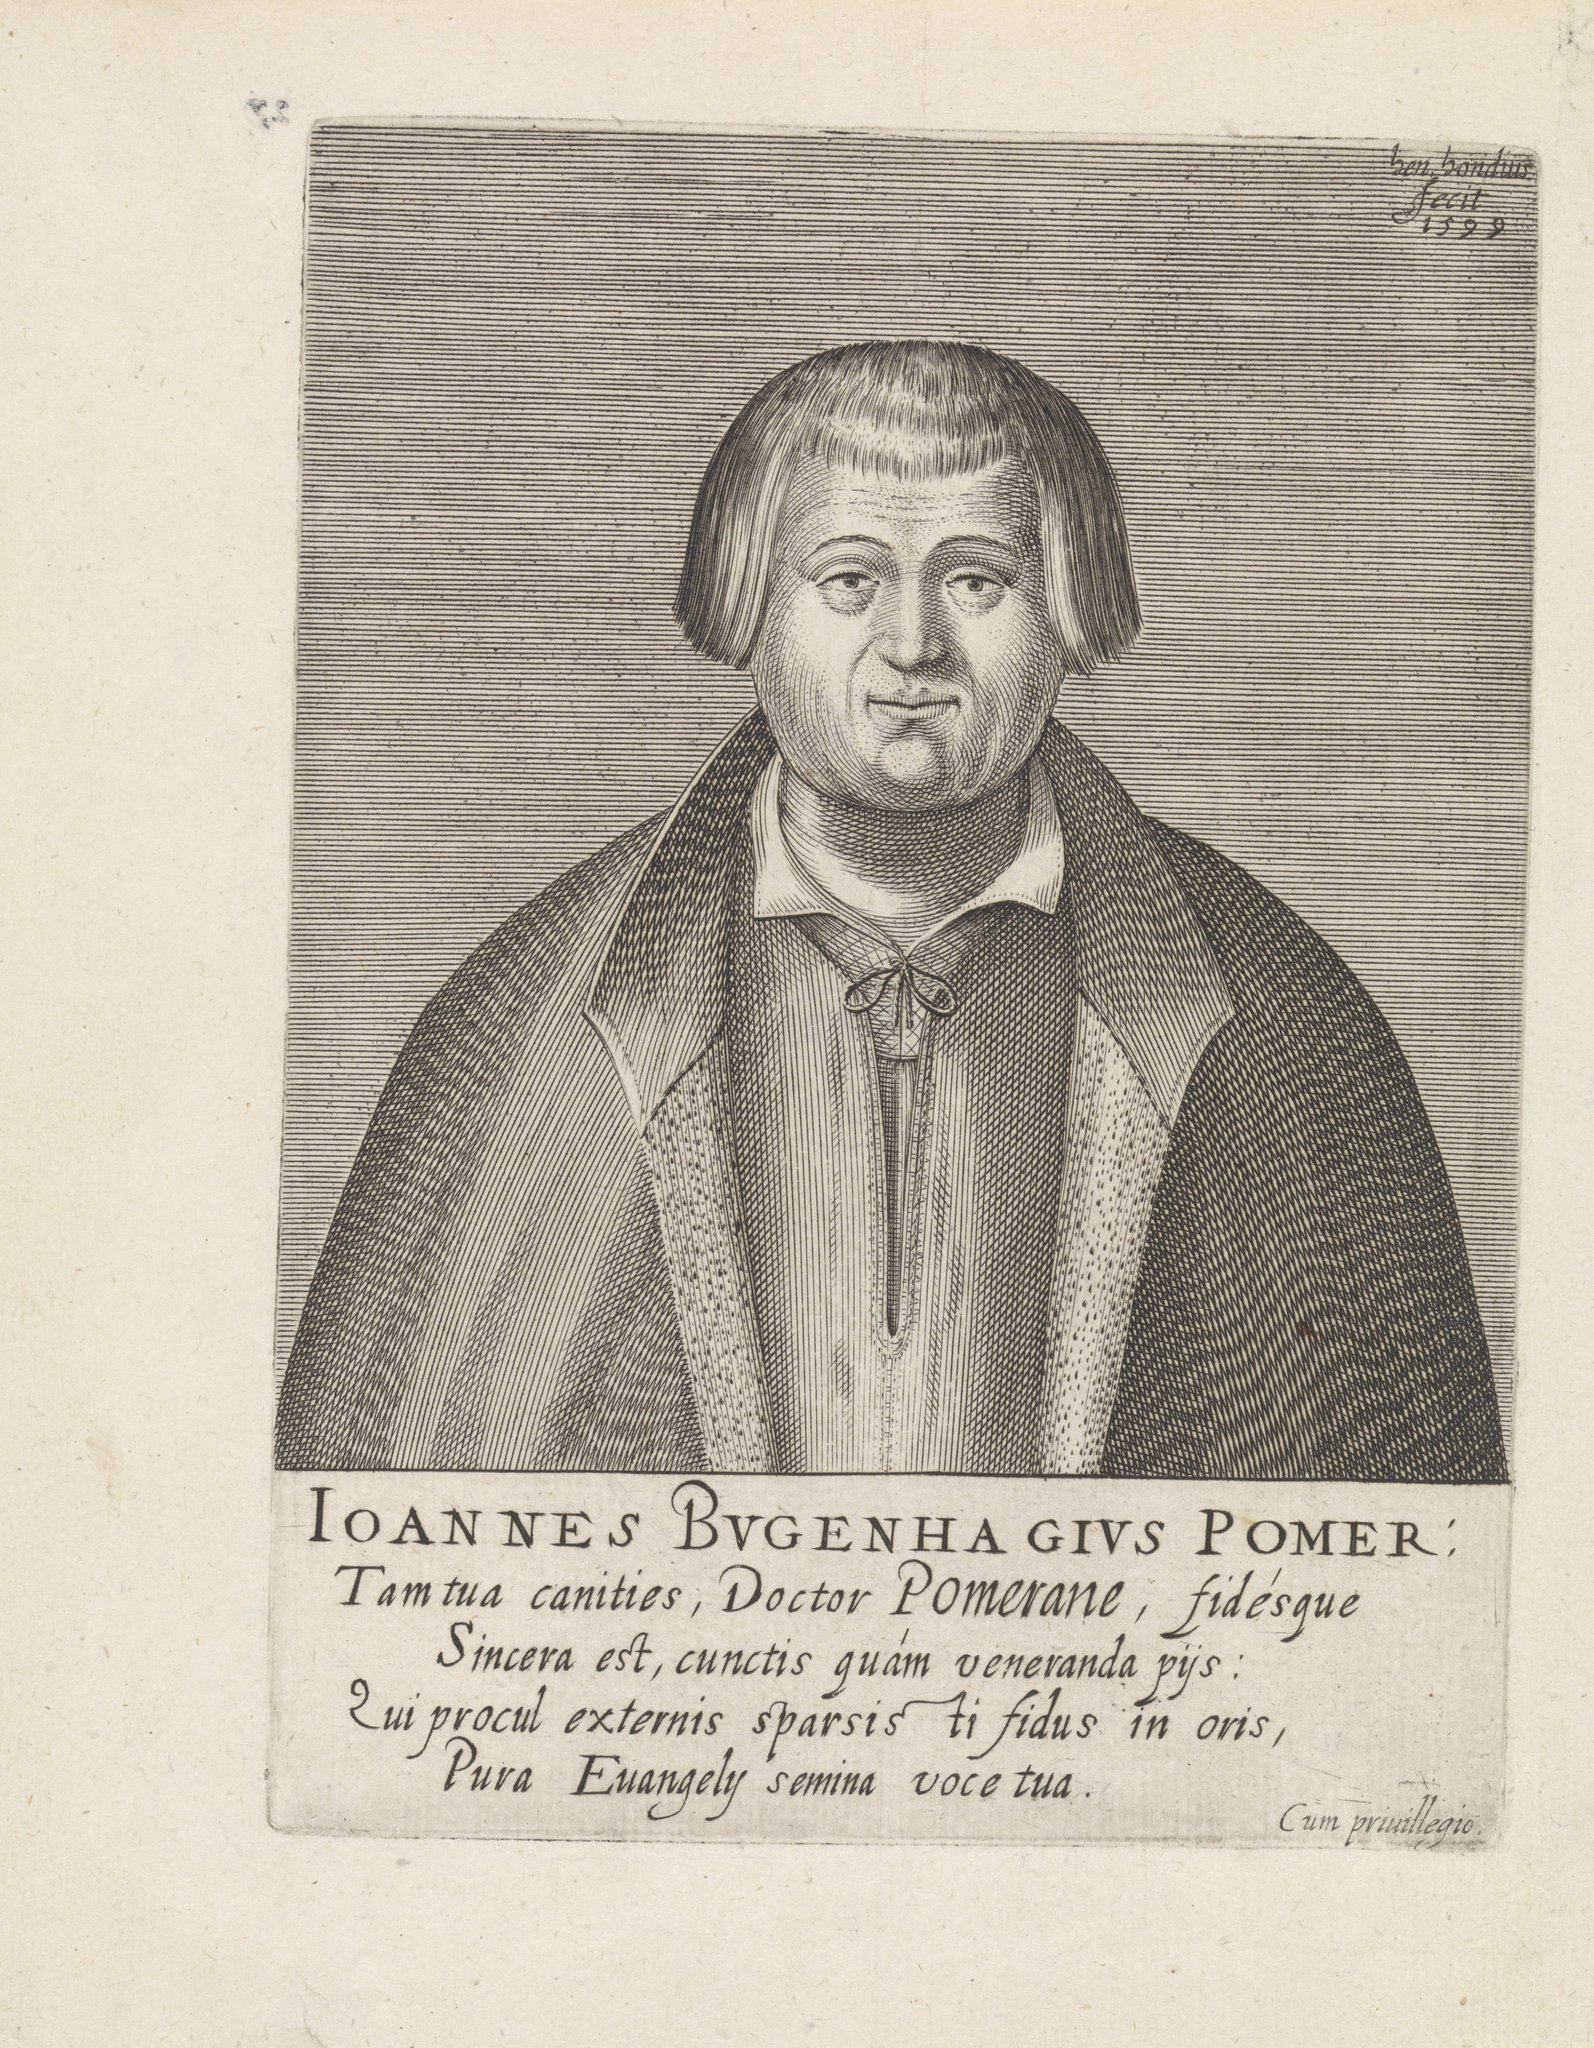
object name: print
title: Portret van Johann Bugenhagen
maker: hendrick hondius (i)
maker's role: draughtsman, print maker, publisher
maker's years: 1573-1650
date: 1599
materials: paper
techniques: engraving, letterpress printing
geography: the hague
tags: wollin, wittenberg, theoloog, historicus, johann bugenhagen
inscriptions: number: ‘27’, collector's mark: Lugt 2228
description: Prent ook gebruikt als boekillustratie in: Jacob Verheiden, Præstantium aliquot theologorum, qui rom. antichristum præcipuè oppugnarunt, effigies. Den Haag: Hendrick Hondius I en Den Haag: B.C. Nieulandt, 1602-1603. Tevens: Arnhem, J.Janssen, 1604.